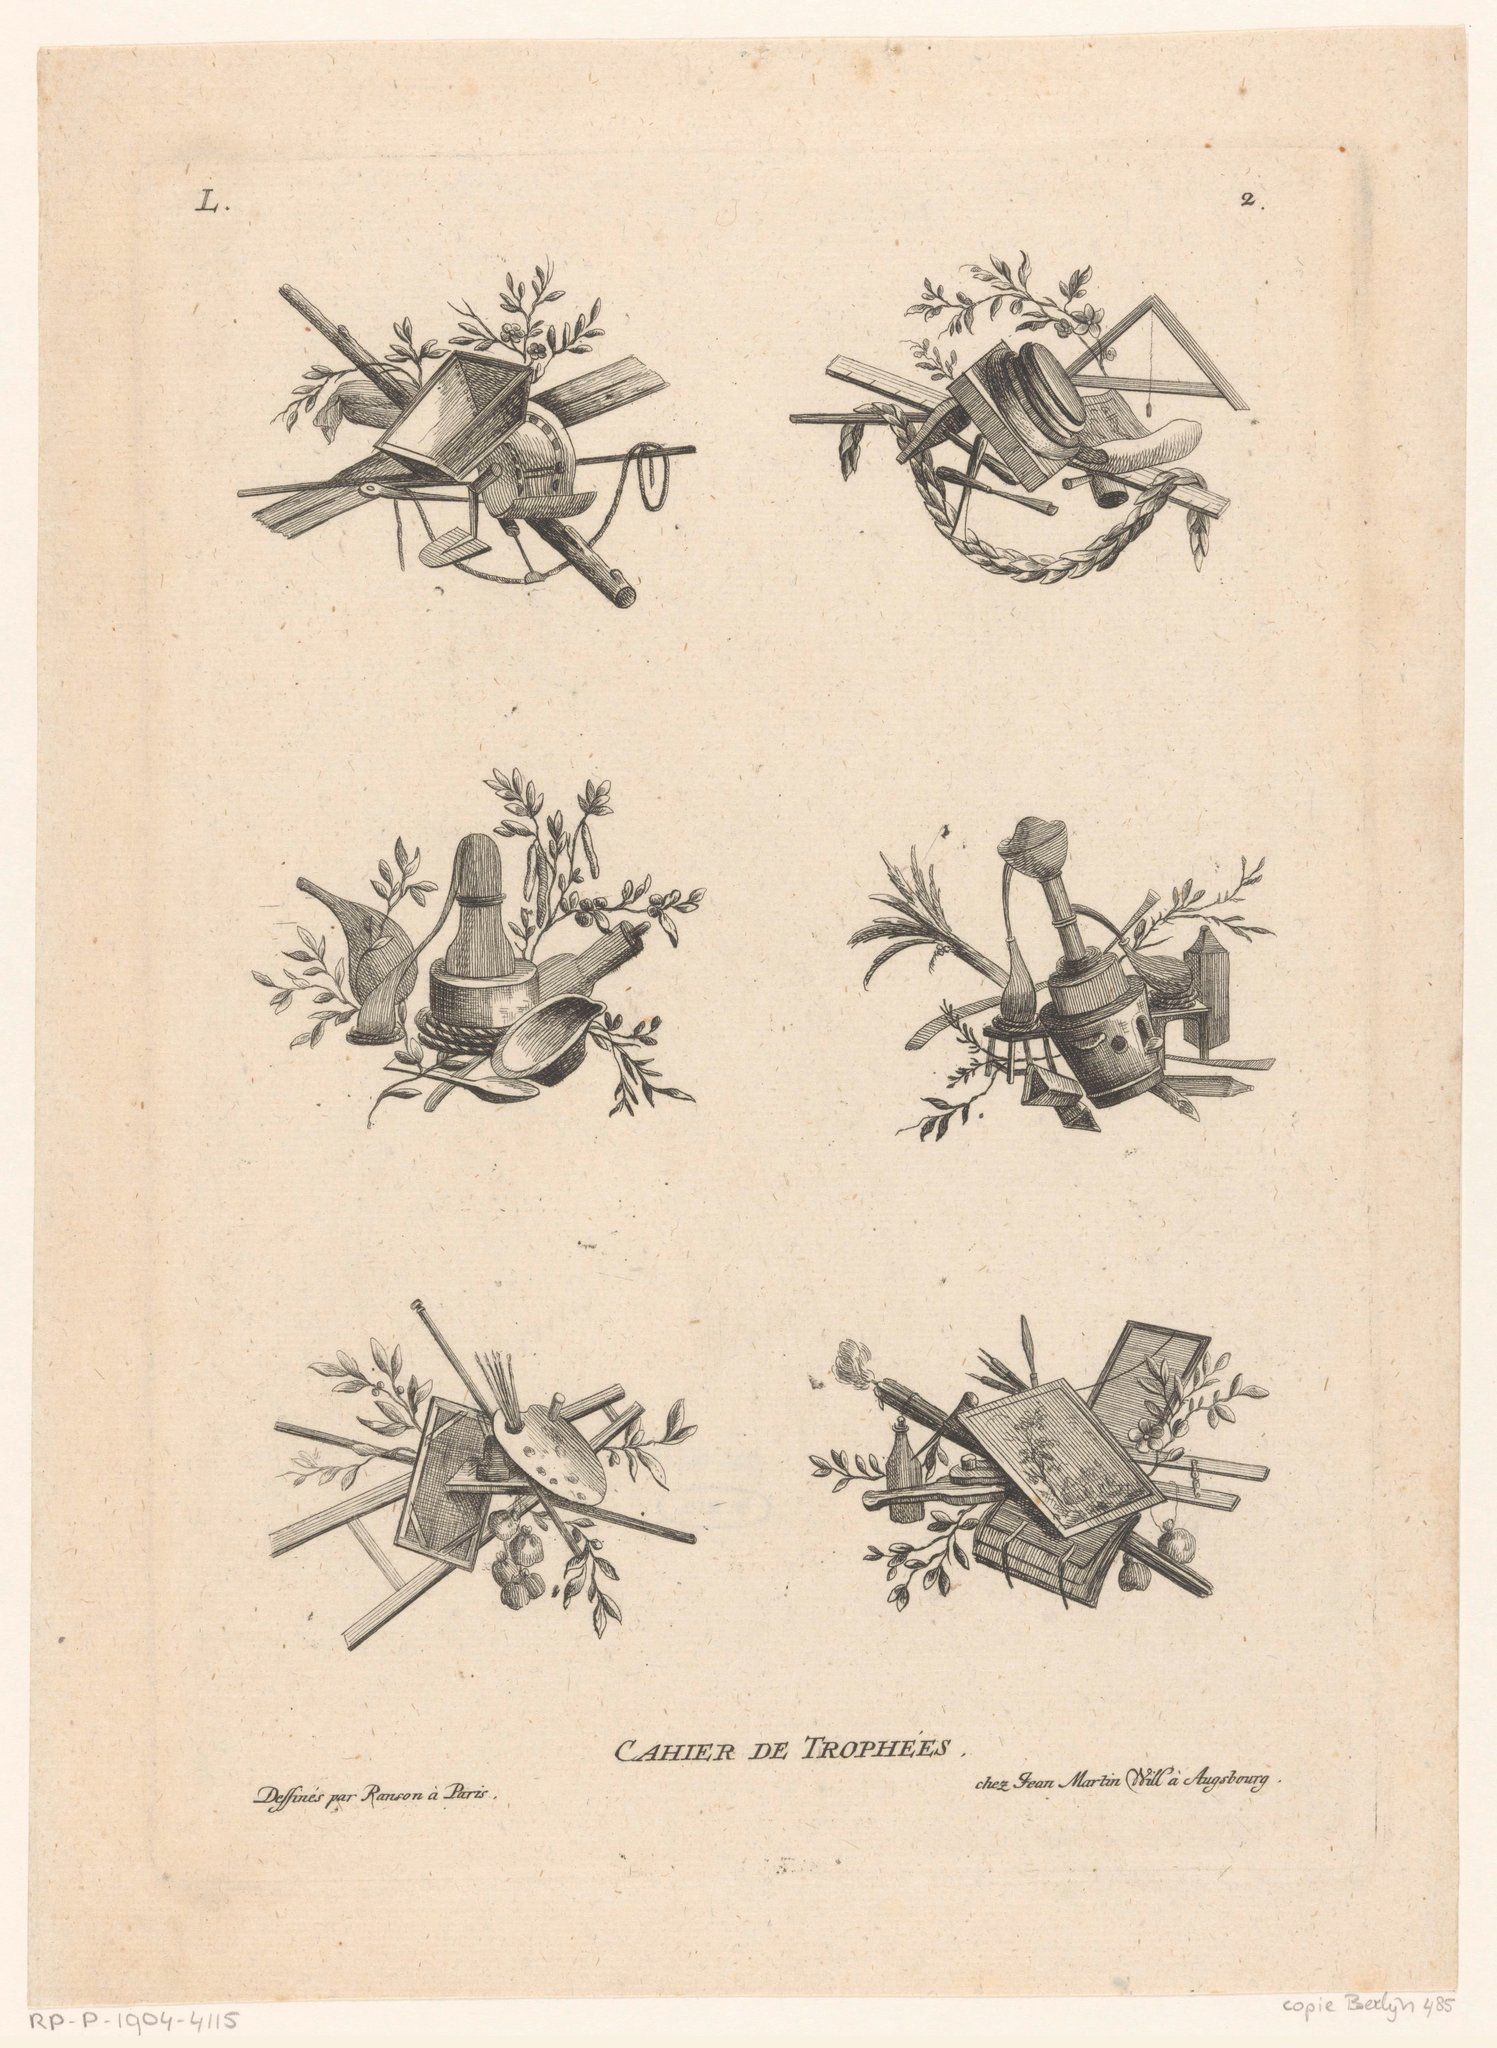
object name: ornament print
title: L Cahier de Trophées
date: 1772-1806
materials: paper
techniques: etching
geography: paris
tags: trophy, i.e.: decorative arrangement of symbolic or typical objects ~ ornament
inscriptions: collector's mark: Lugt 2228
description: Zes trofeeën met diverse attributen zoals een houten bak, meetinstrumenten en schildersattributen.